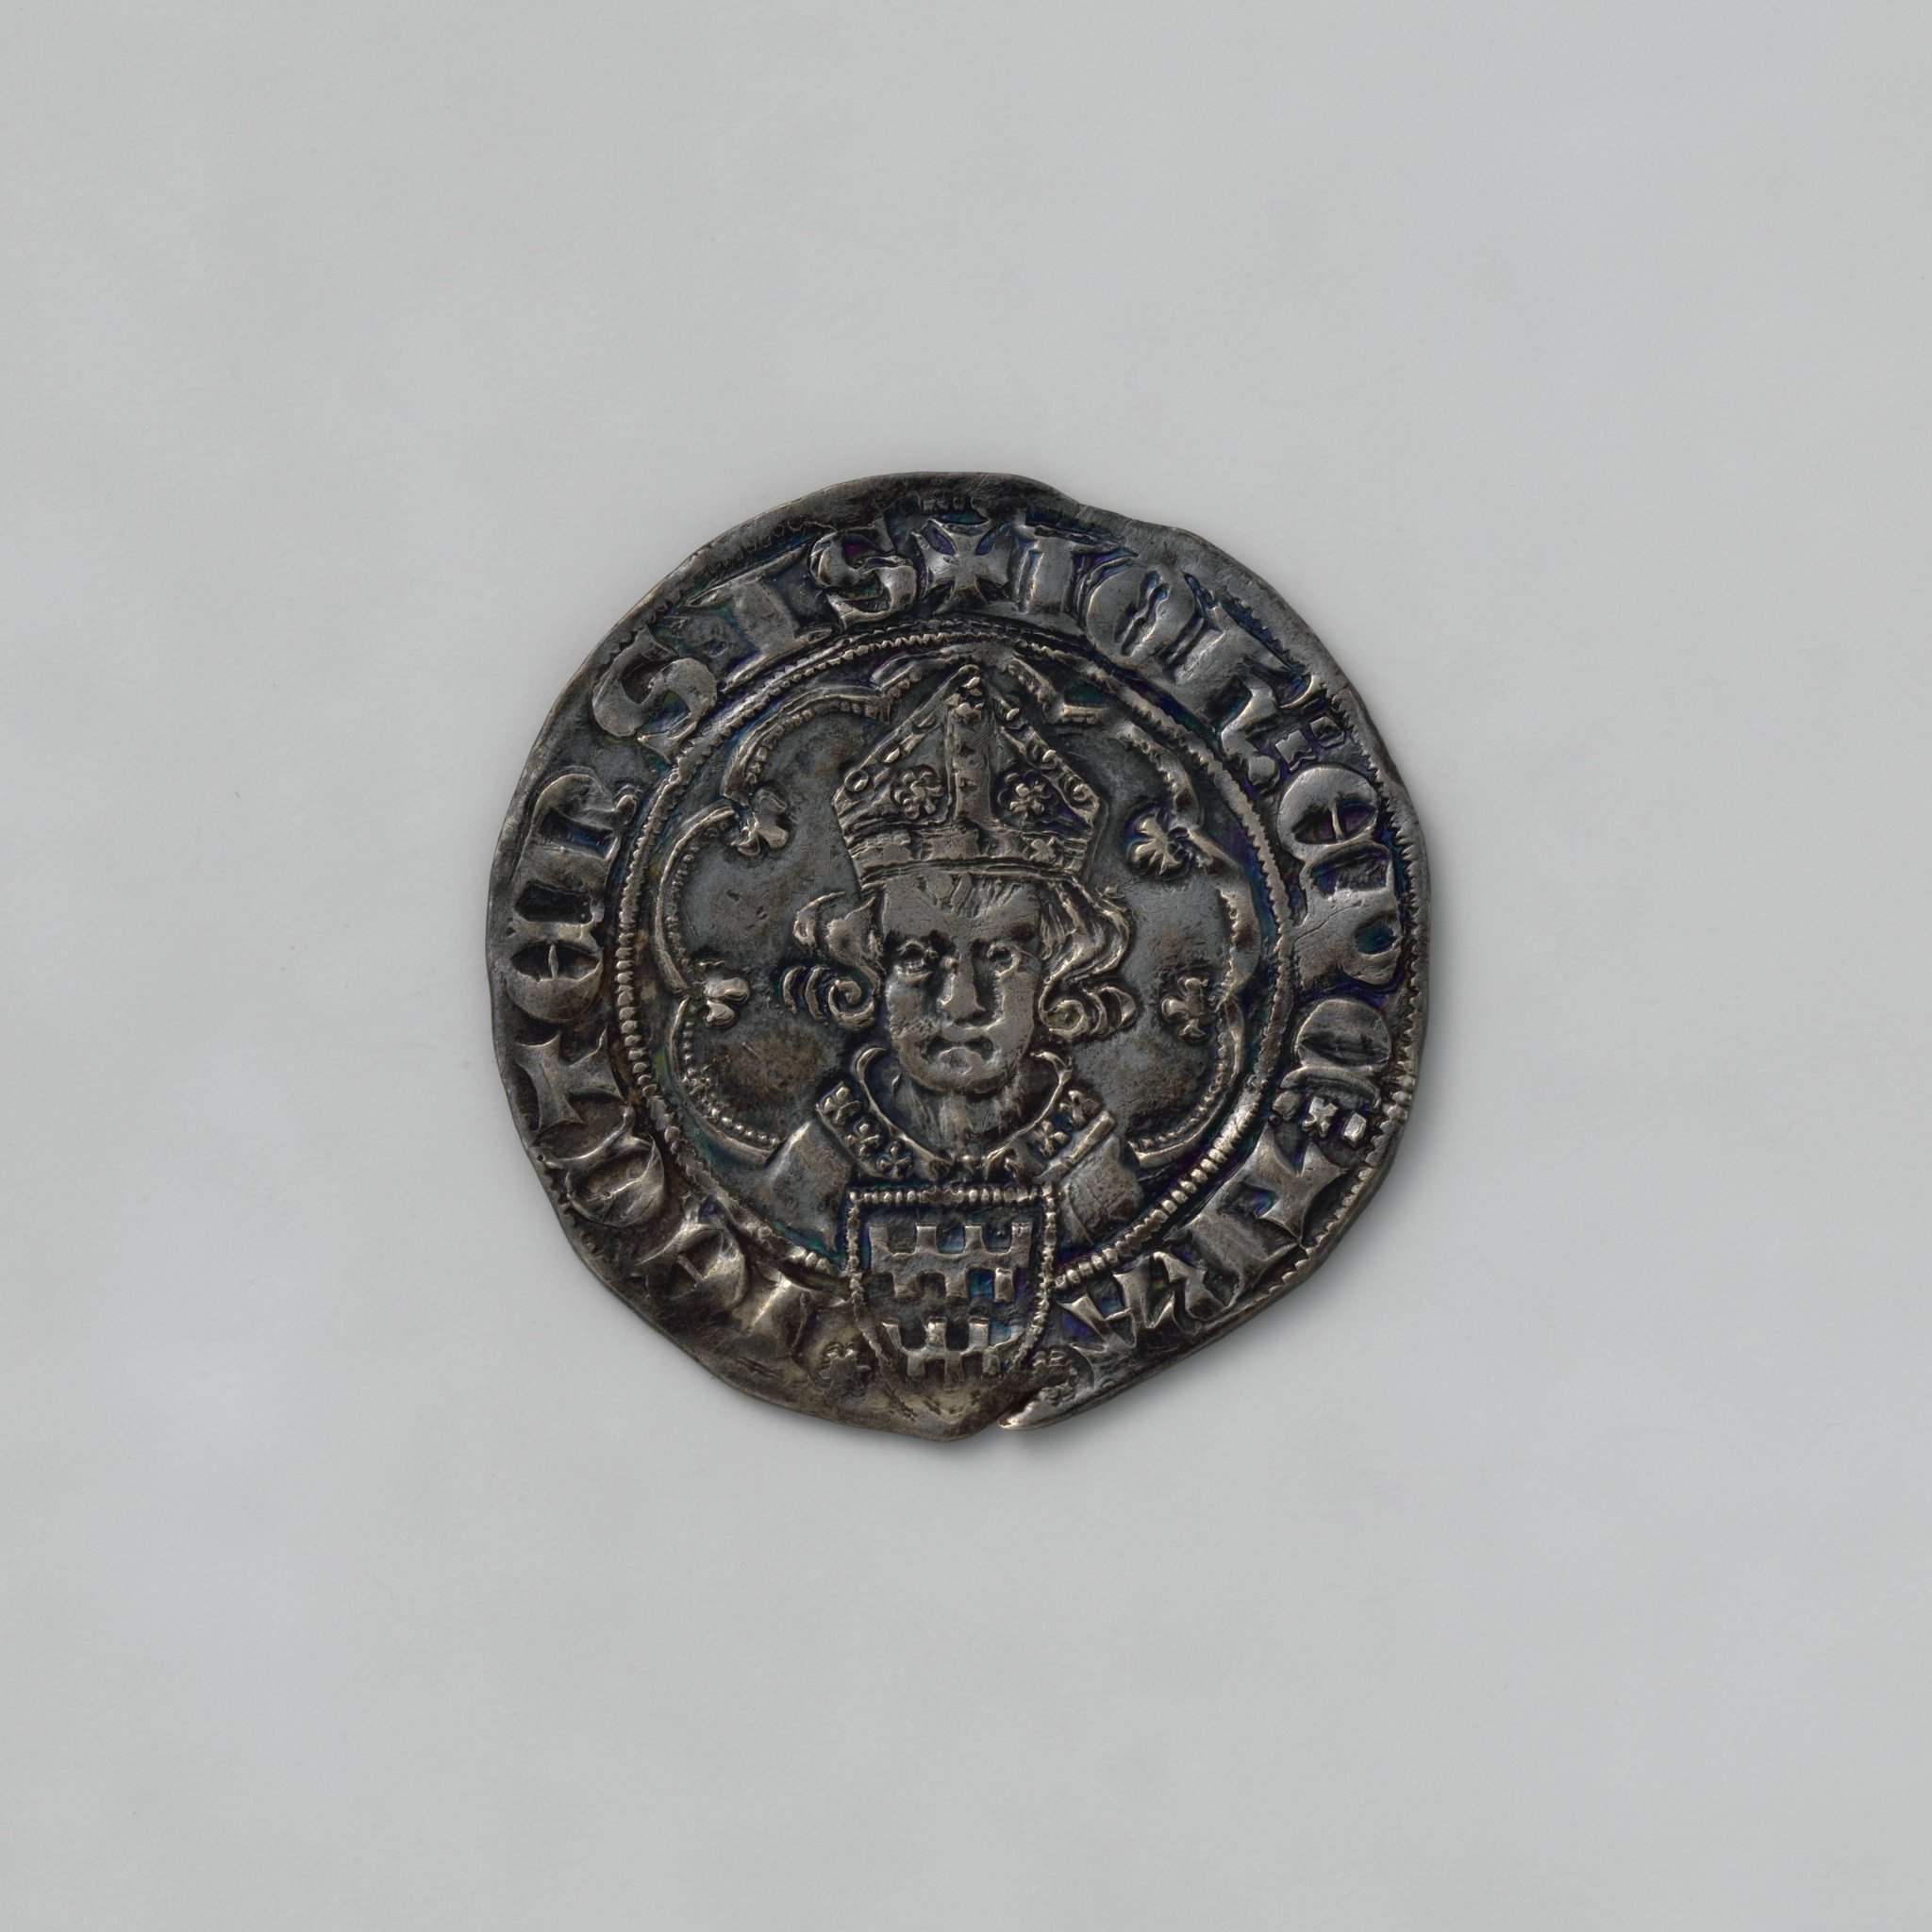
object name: coin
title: Utrechtse groot van Jan van Arkel, 1341-1364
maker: hendrik i van vianden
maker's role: bisschop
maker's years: -1267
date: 1341-1364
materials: silver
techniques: striking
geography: utrecht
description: Voorzijde: binnen versierde veelpas aanziend portret van de bisschop met mijter met voor zich wapenschild van Arkel. Keerzijde: halflang gevoet kruis. Dubbel omschrift.